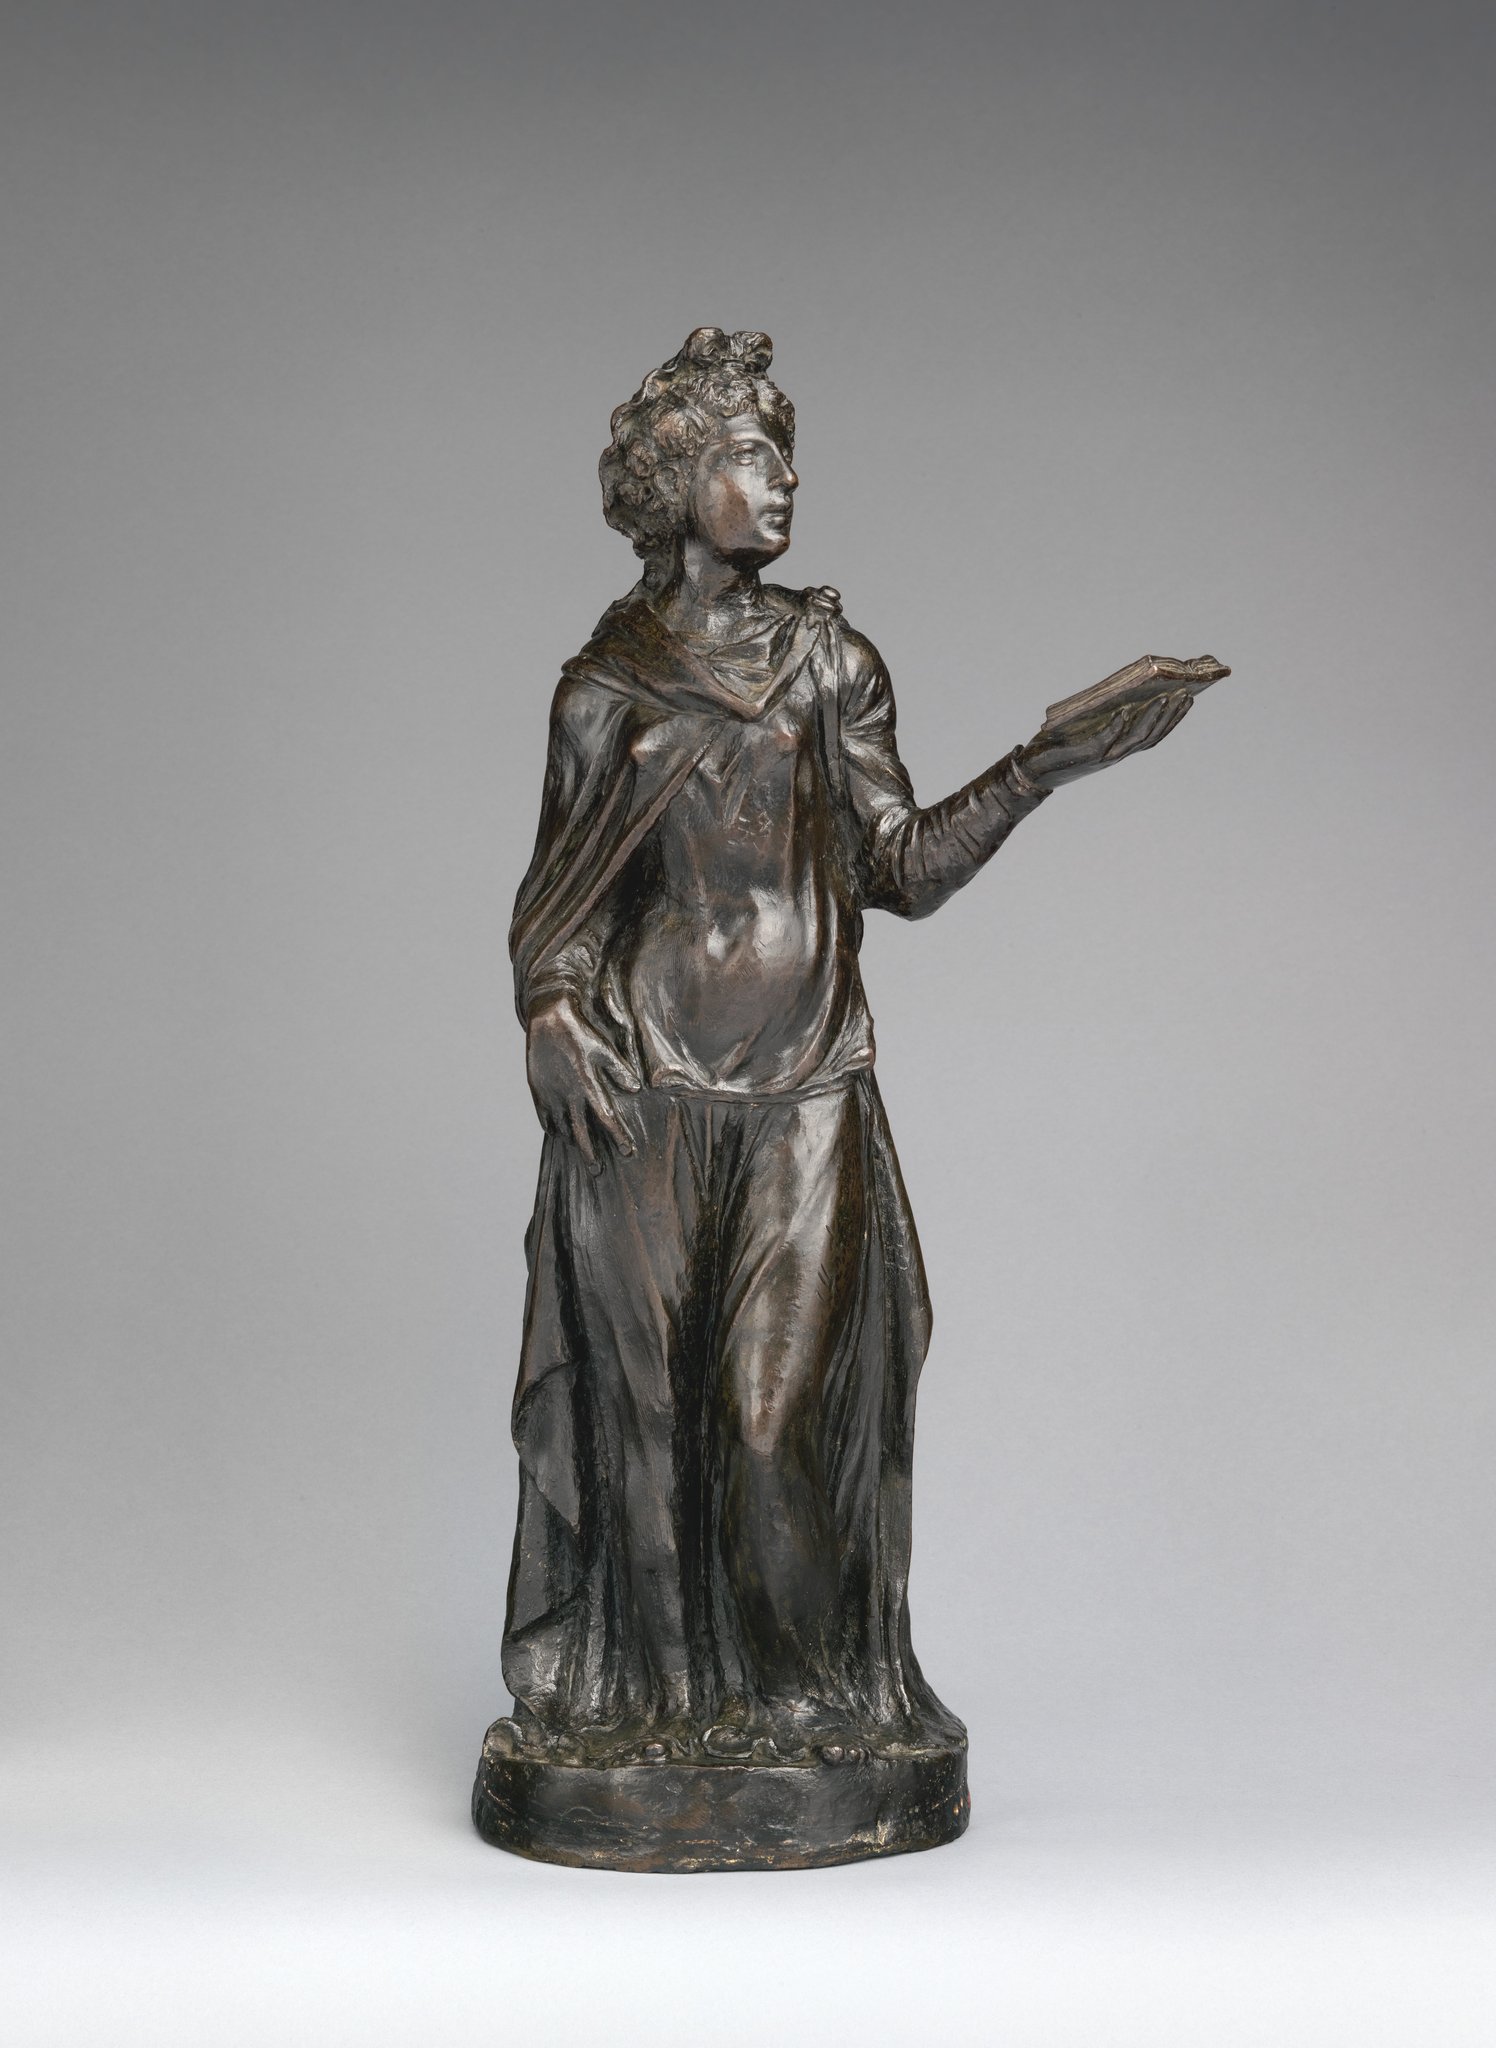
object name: statuette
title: Sibyl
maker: agostino zoppo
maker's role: artist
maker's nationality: italian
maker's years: 1515-1572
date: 1534-1566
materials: bronze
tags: sibyl